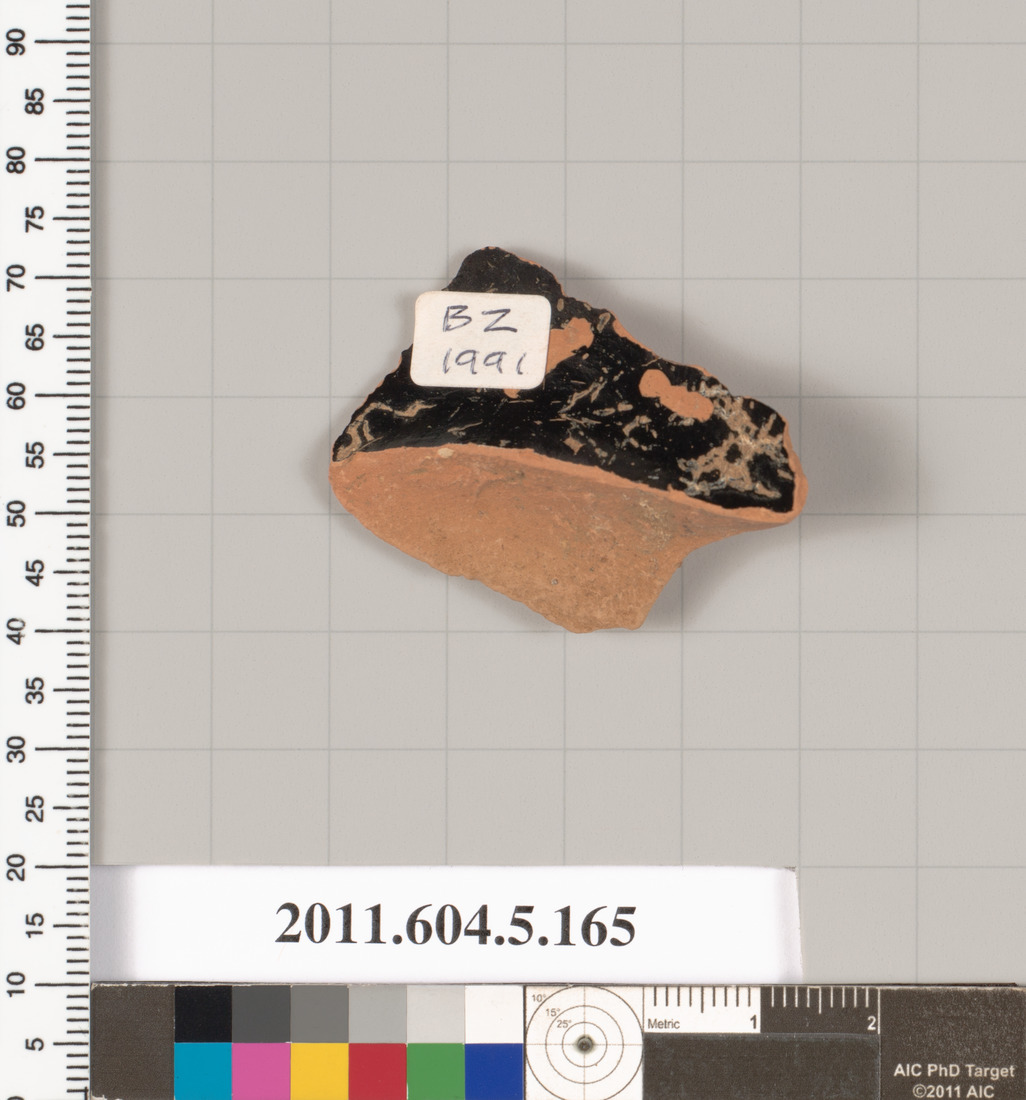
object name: kylix fragment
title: Terracotta rim fragment of a kylix (drinking cup)?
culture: greek, attic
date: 600-401 BCE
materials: terracotta